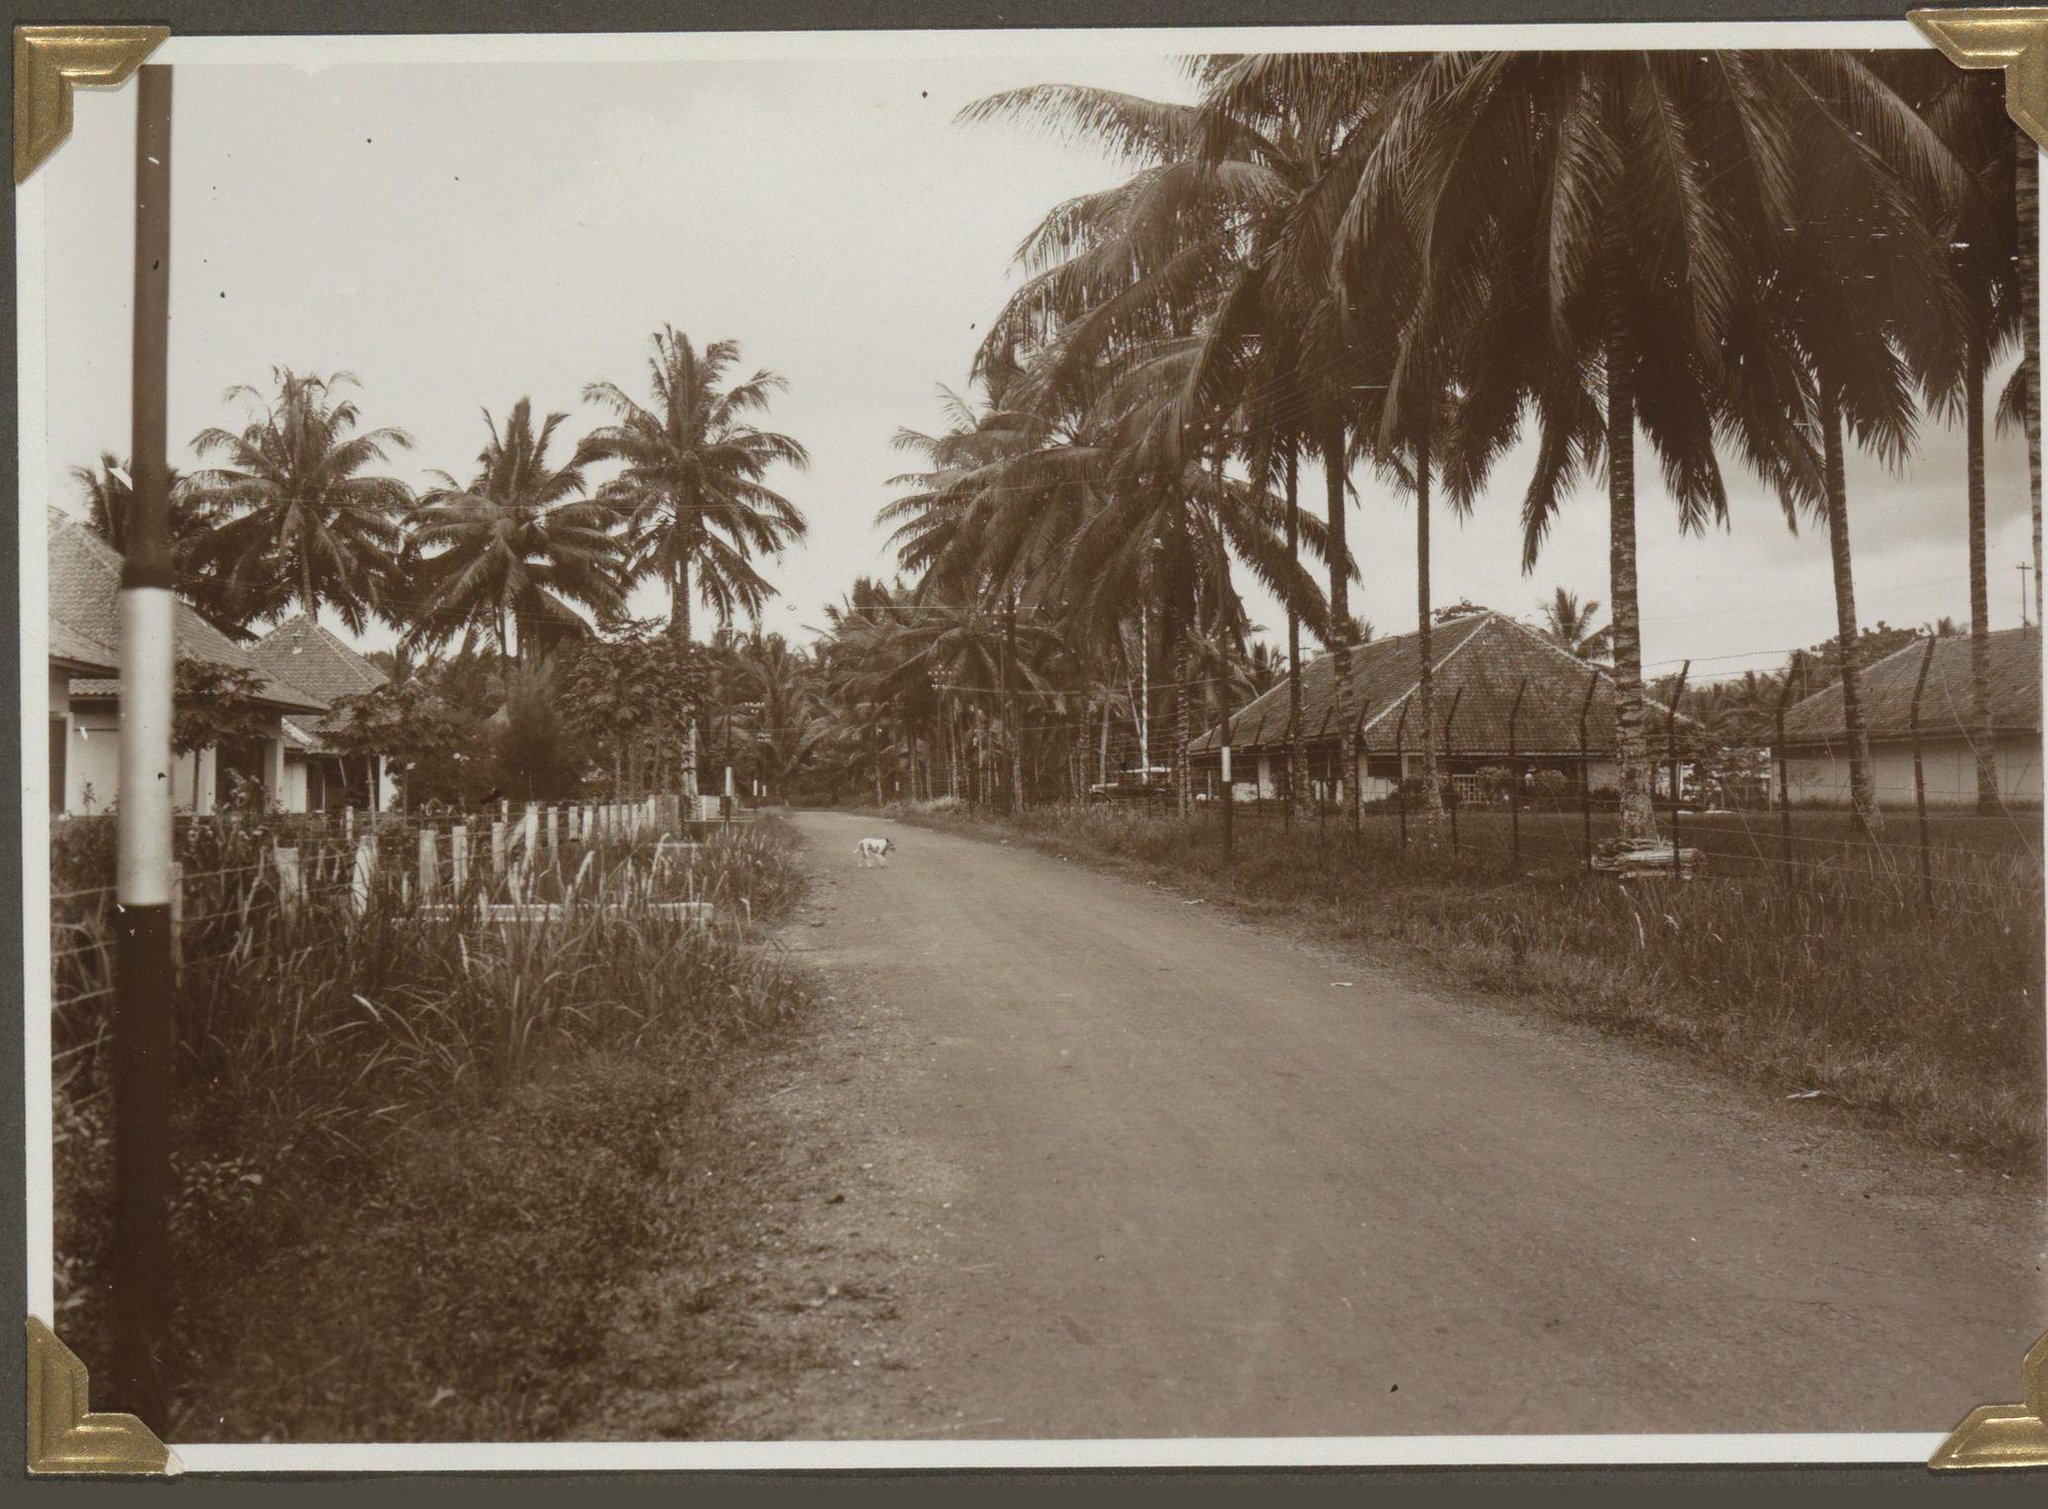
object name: photograph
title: Tangsiweg in Lampong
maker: Anonymous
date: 1932-1933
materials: photographic support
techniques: gelatin silver print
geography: lampung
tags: forest path or lane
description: Onderdeel van Herinneringsalbum voor F.J. Junius, vertrekkend resident van Lampong (Zuid-Sumatra).